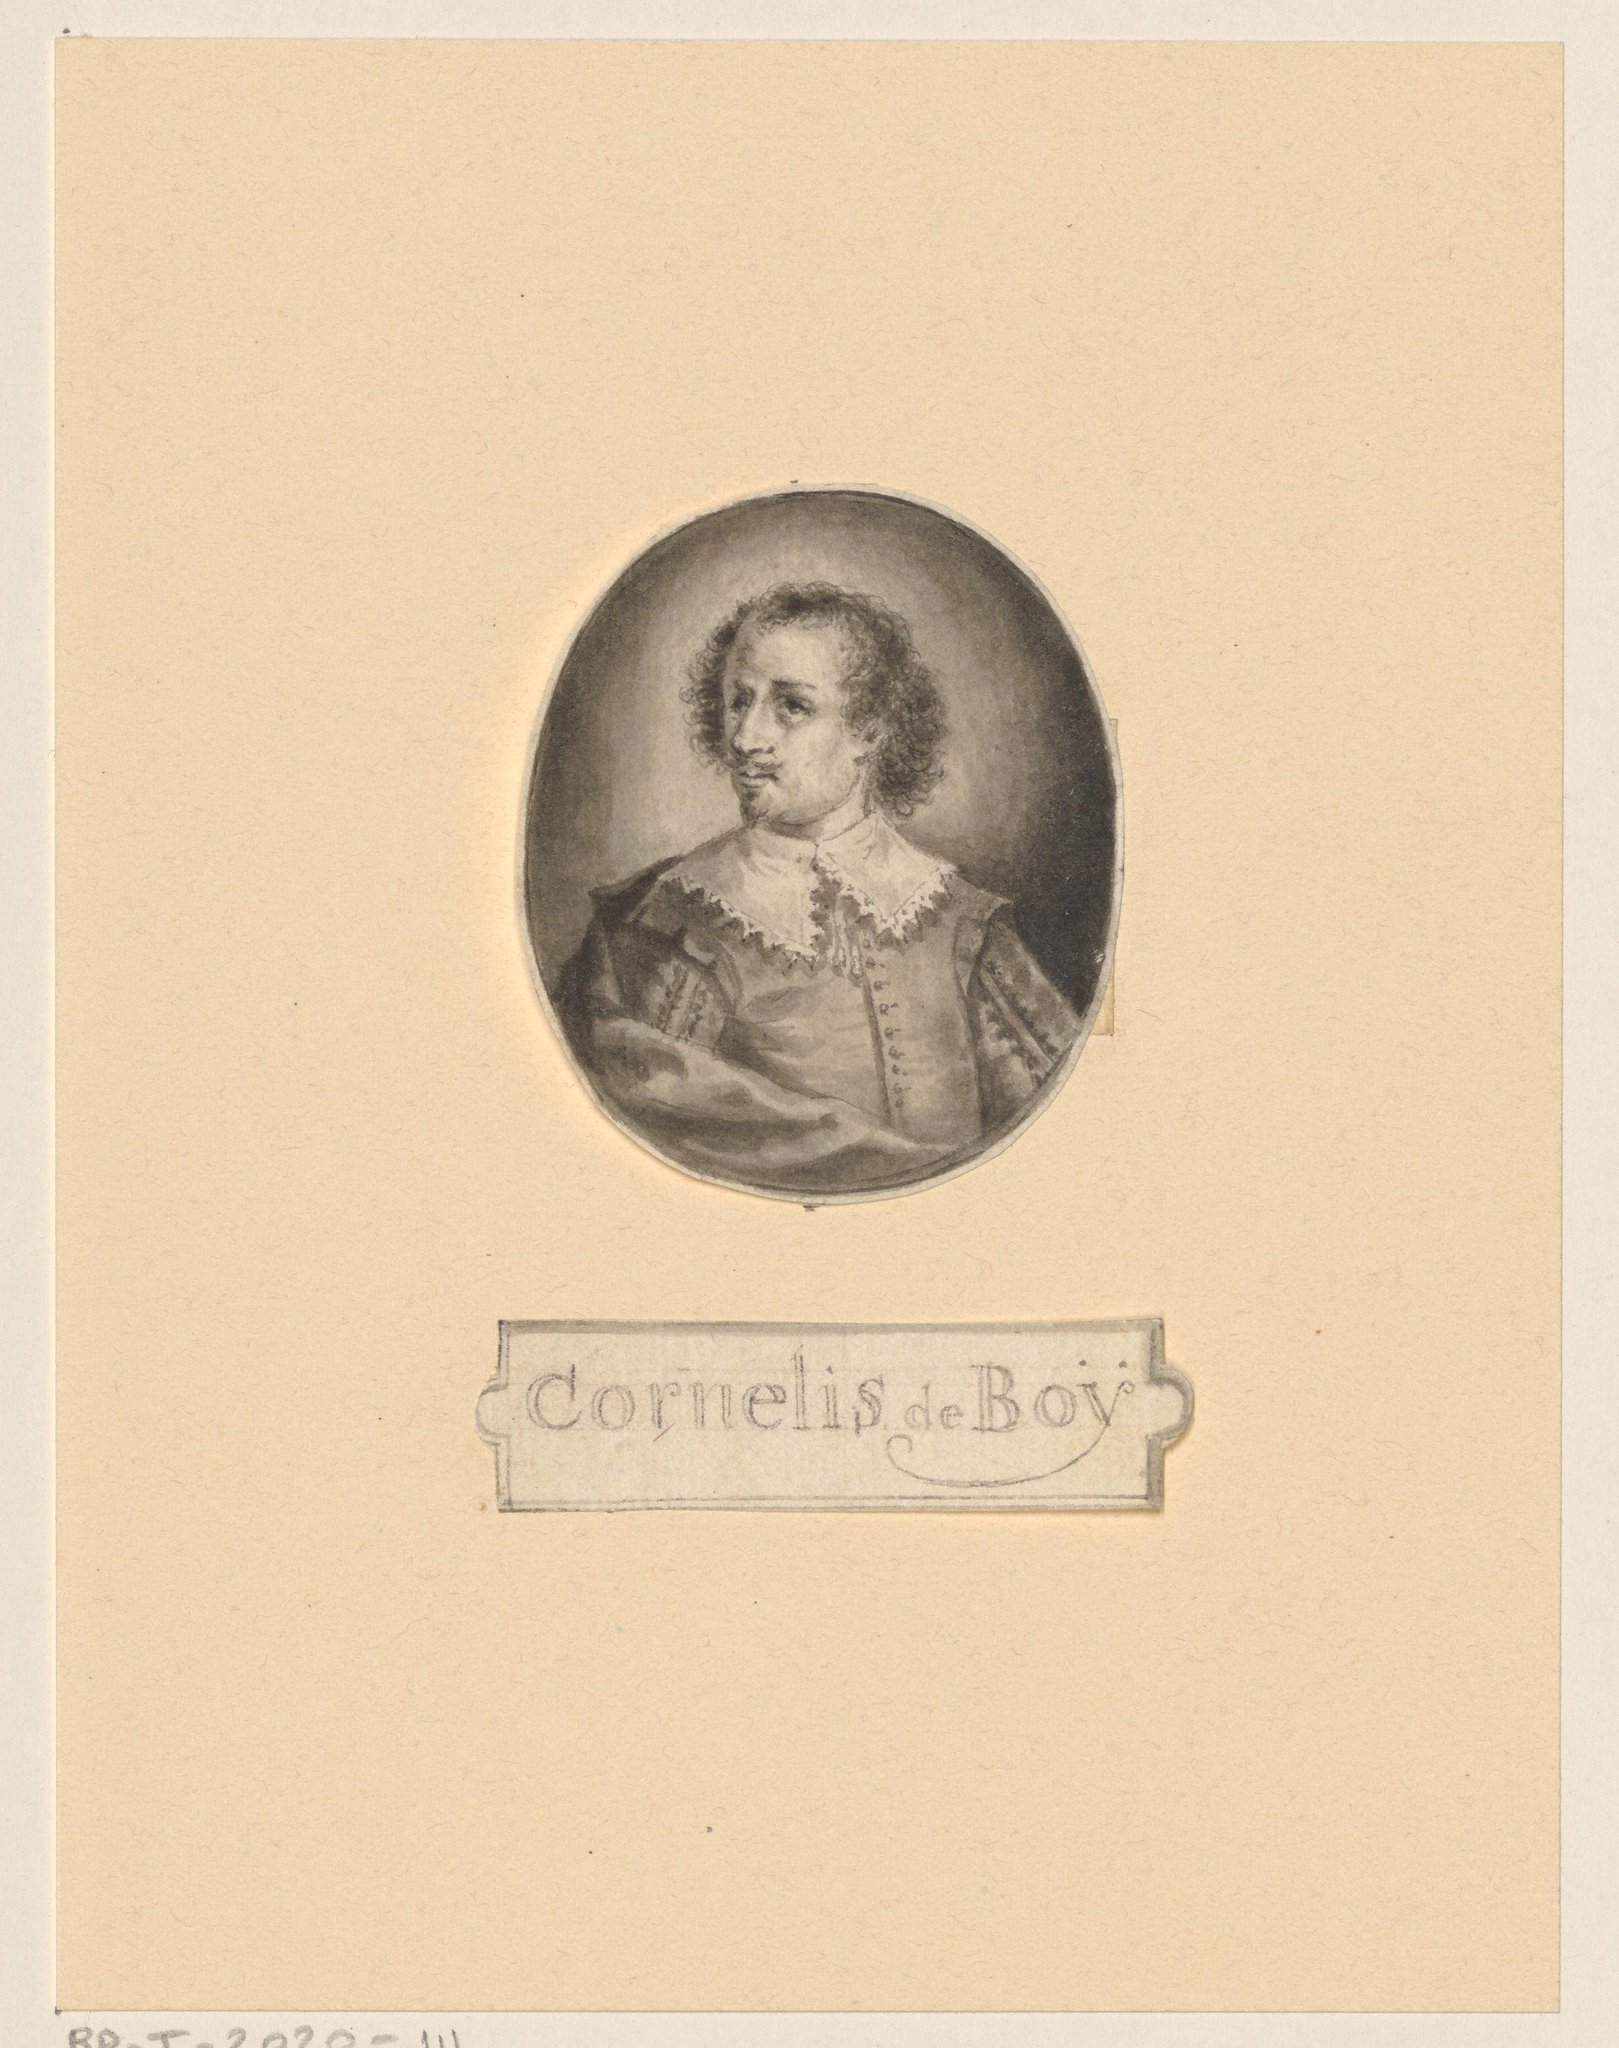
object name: drawing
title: Portret van Cornelis Boey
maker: Anonymous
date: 1650-1749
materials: paper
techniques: brush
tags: the hague, cornelis boey, historical persons, portrait of a writer